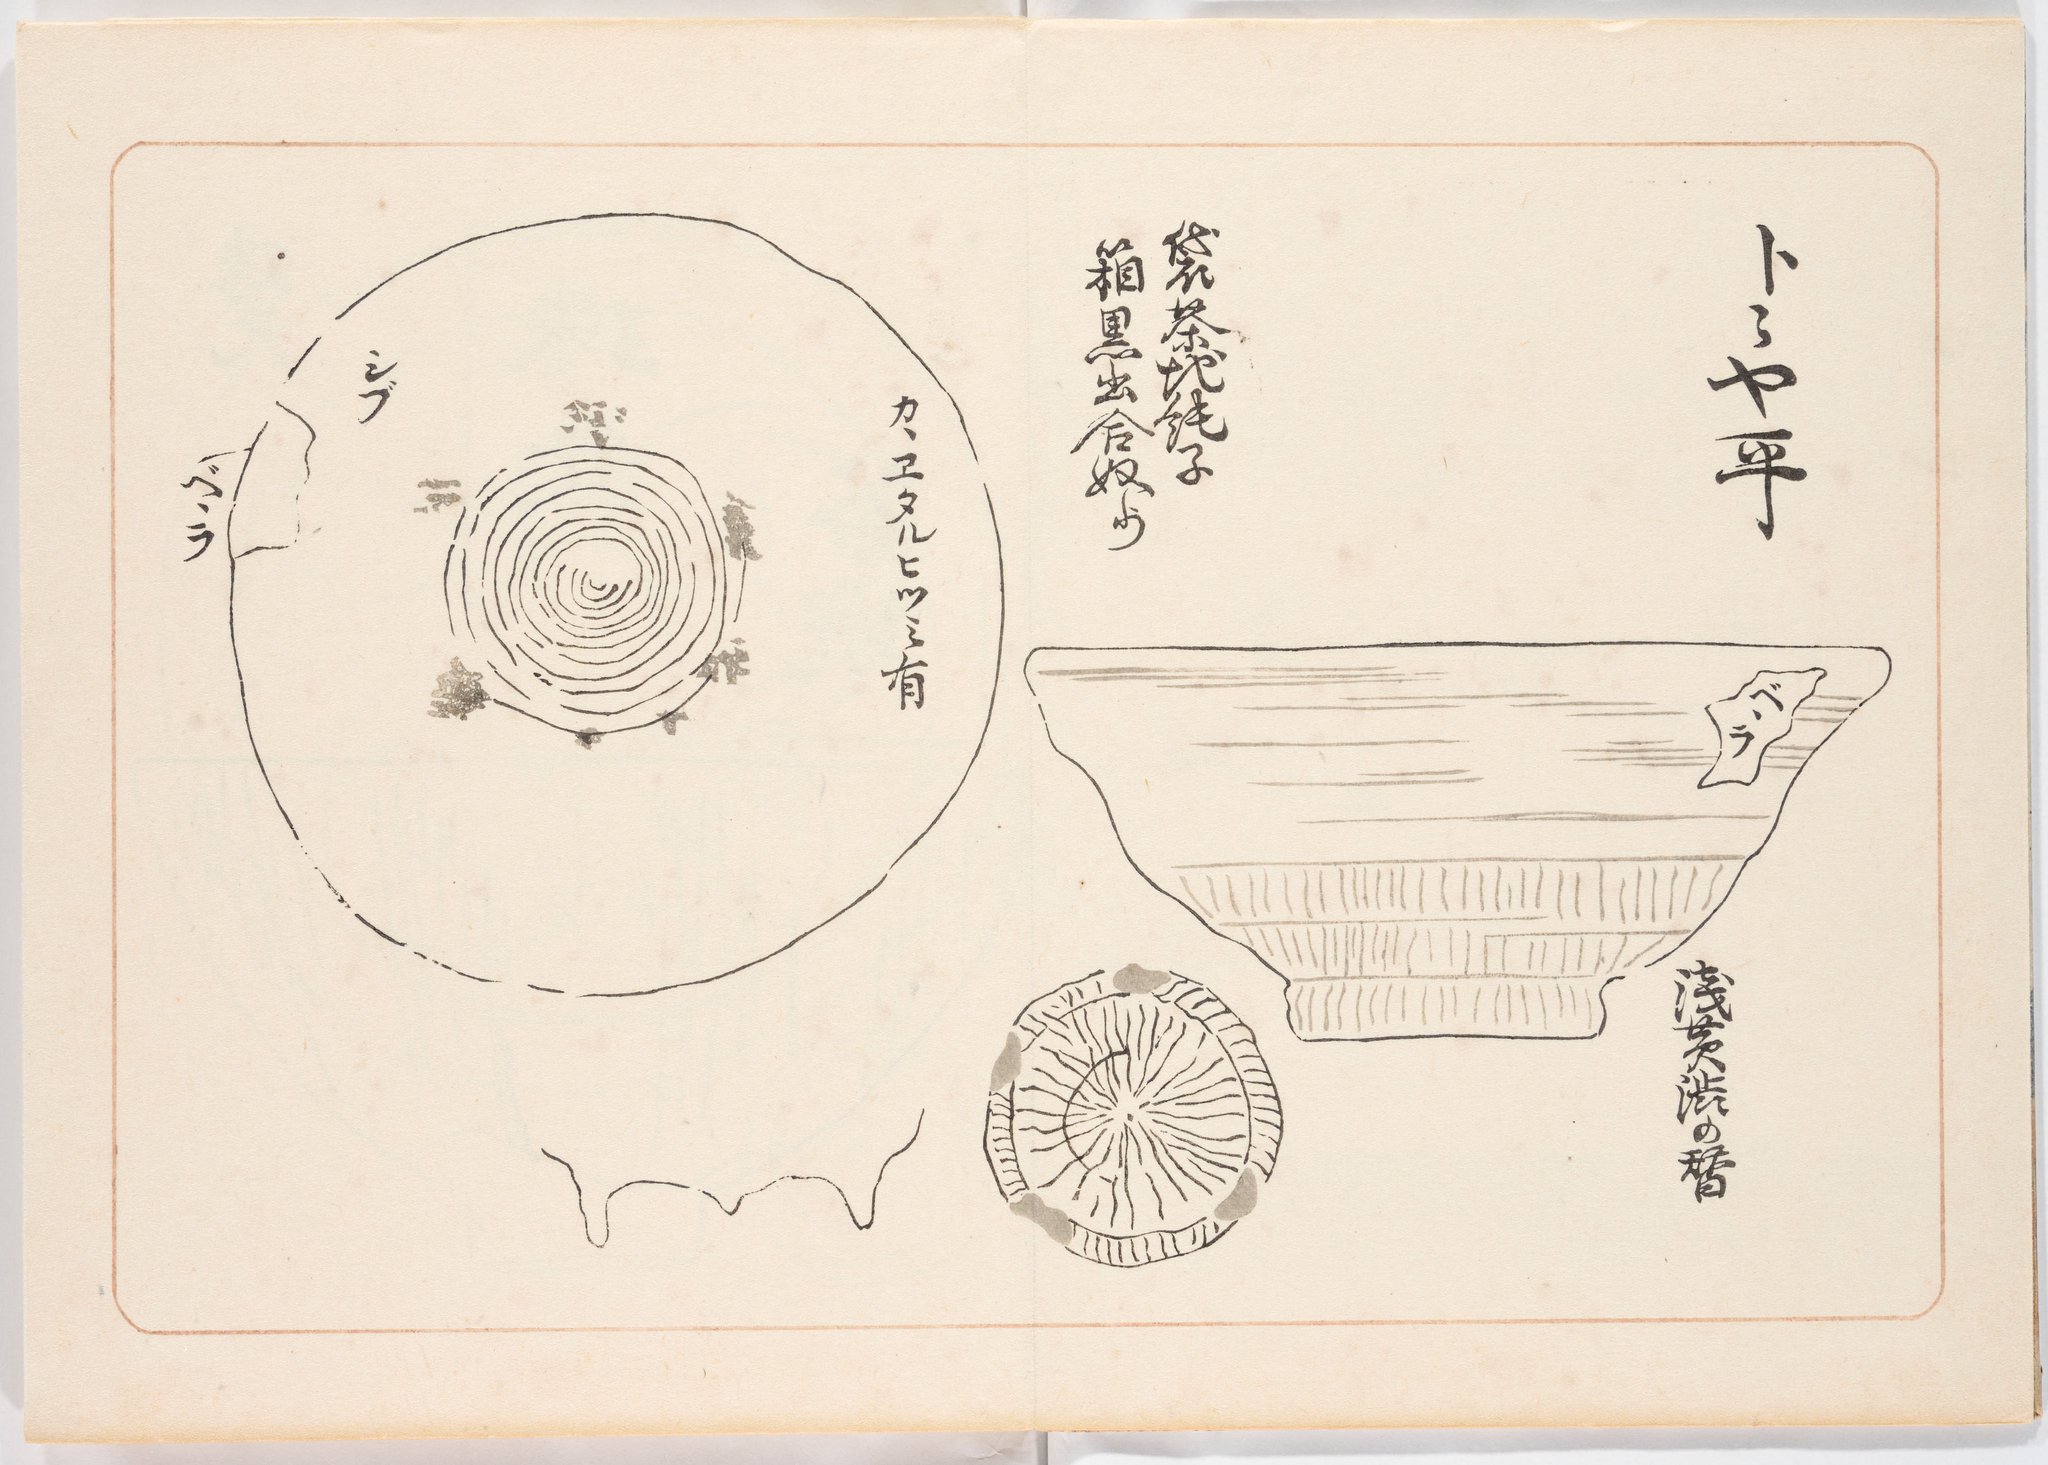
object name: illustrated book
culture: japanese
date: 1893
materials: ink, paper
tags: bowls